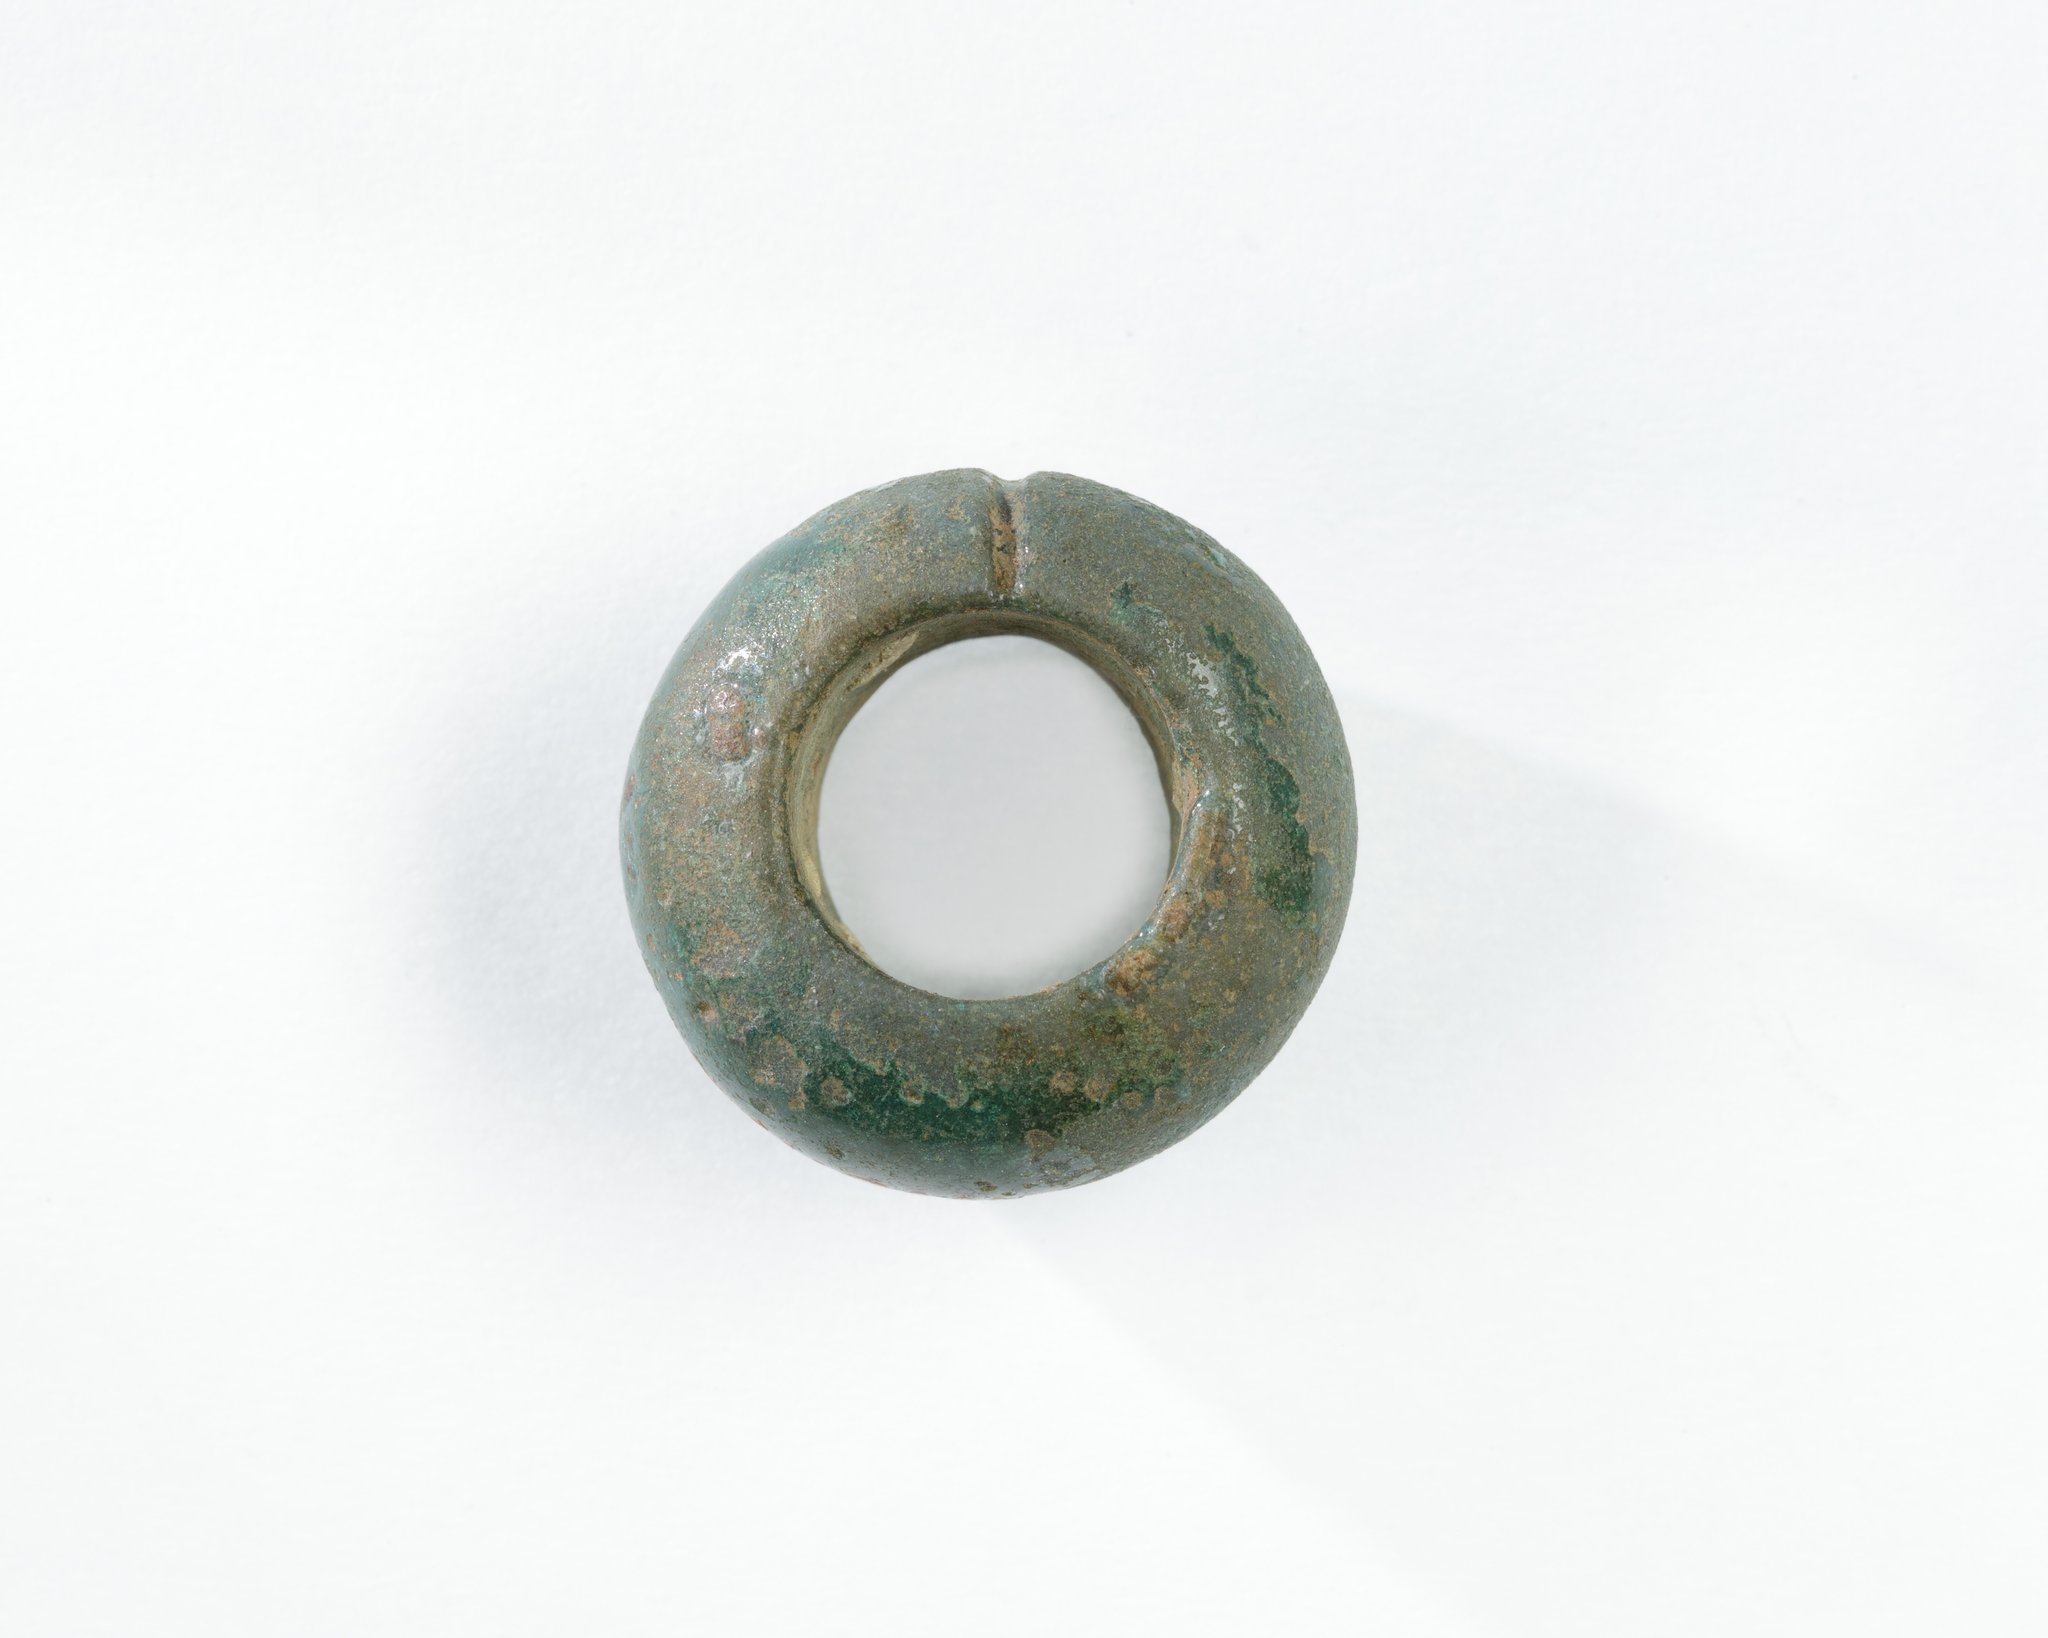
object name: earring, penannular, circular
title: Penannular Earring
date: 1550-1295 BCE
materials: glass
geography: northern upper egypt